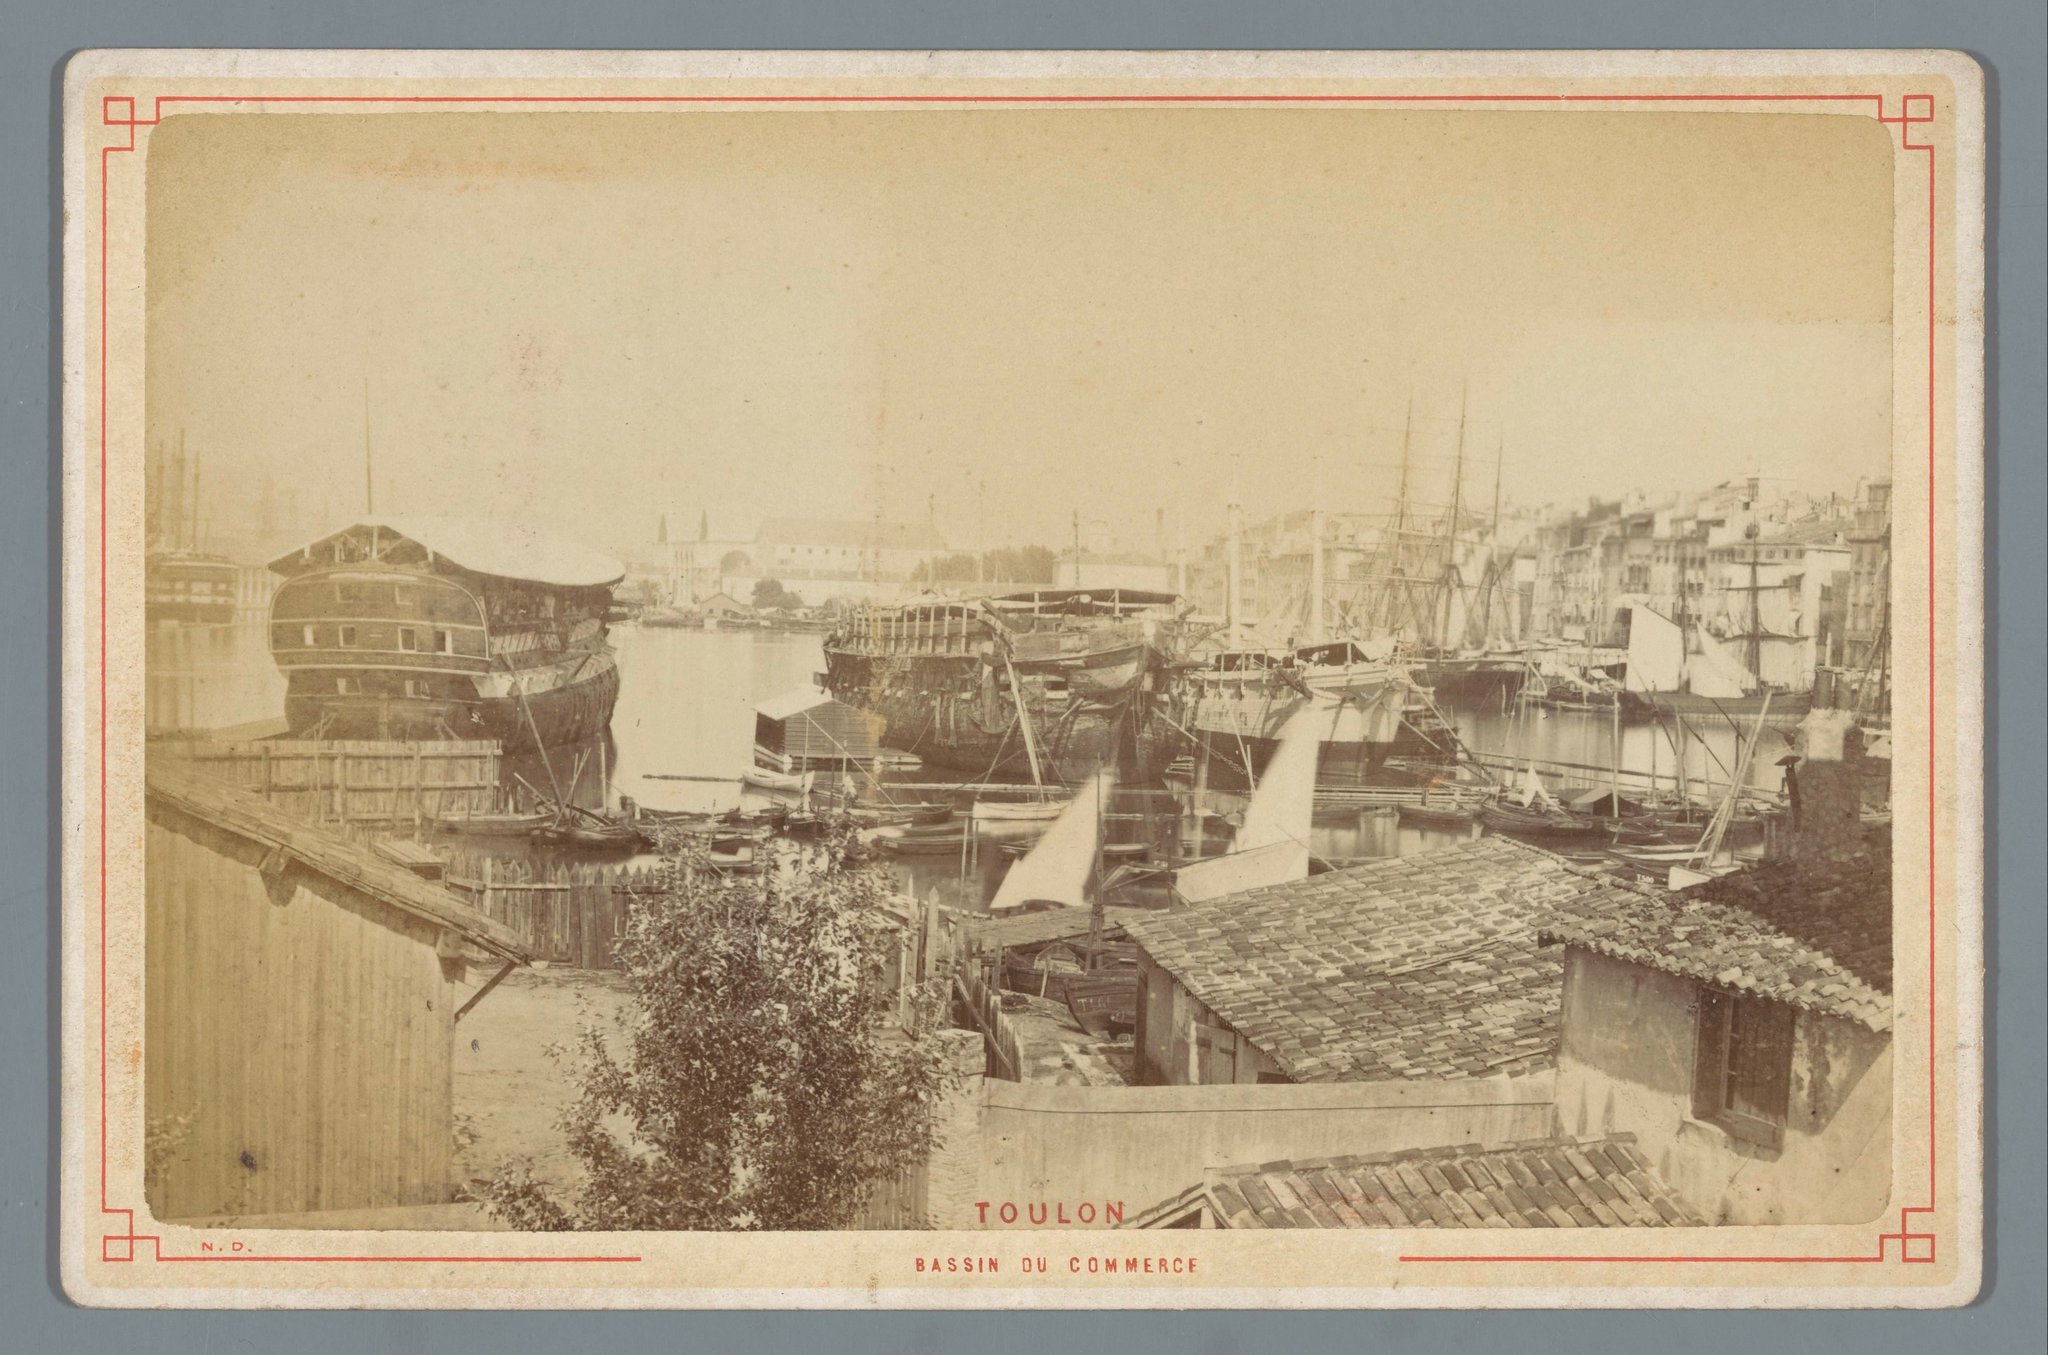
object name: cabinet photograph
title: Bassin du Commerce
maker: étienne neurdein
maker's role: publisher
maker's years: 1832-1918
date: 1870-1900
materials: cardboard, photographic support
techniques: albumen print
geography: toulon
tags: harbour, toulon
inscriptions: initials: ‘N.D.’